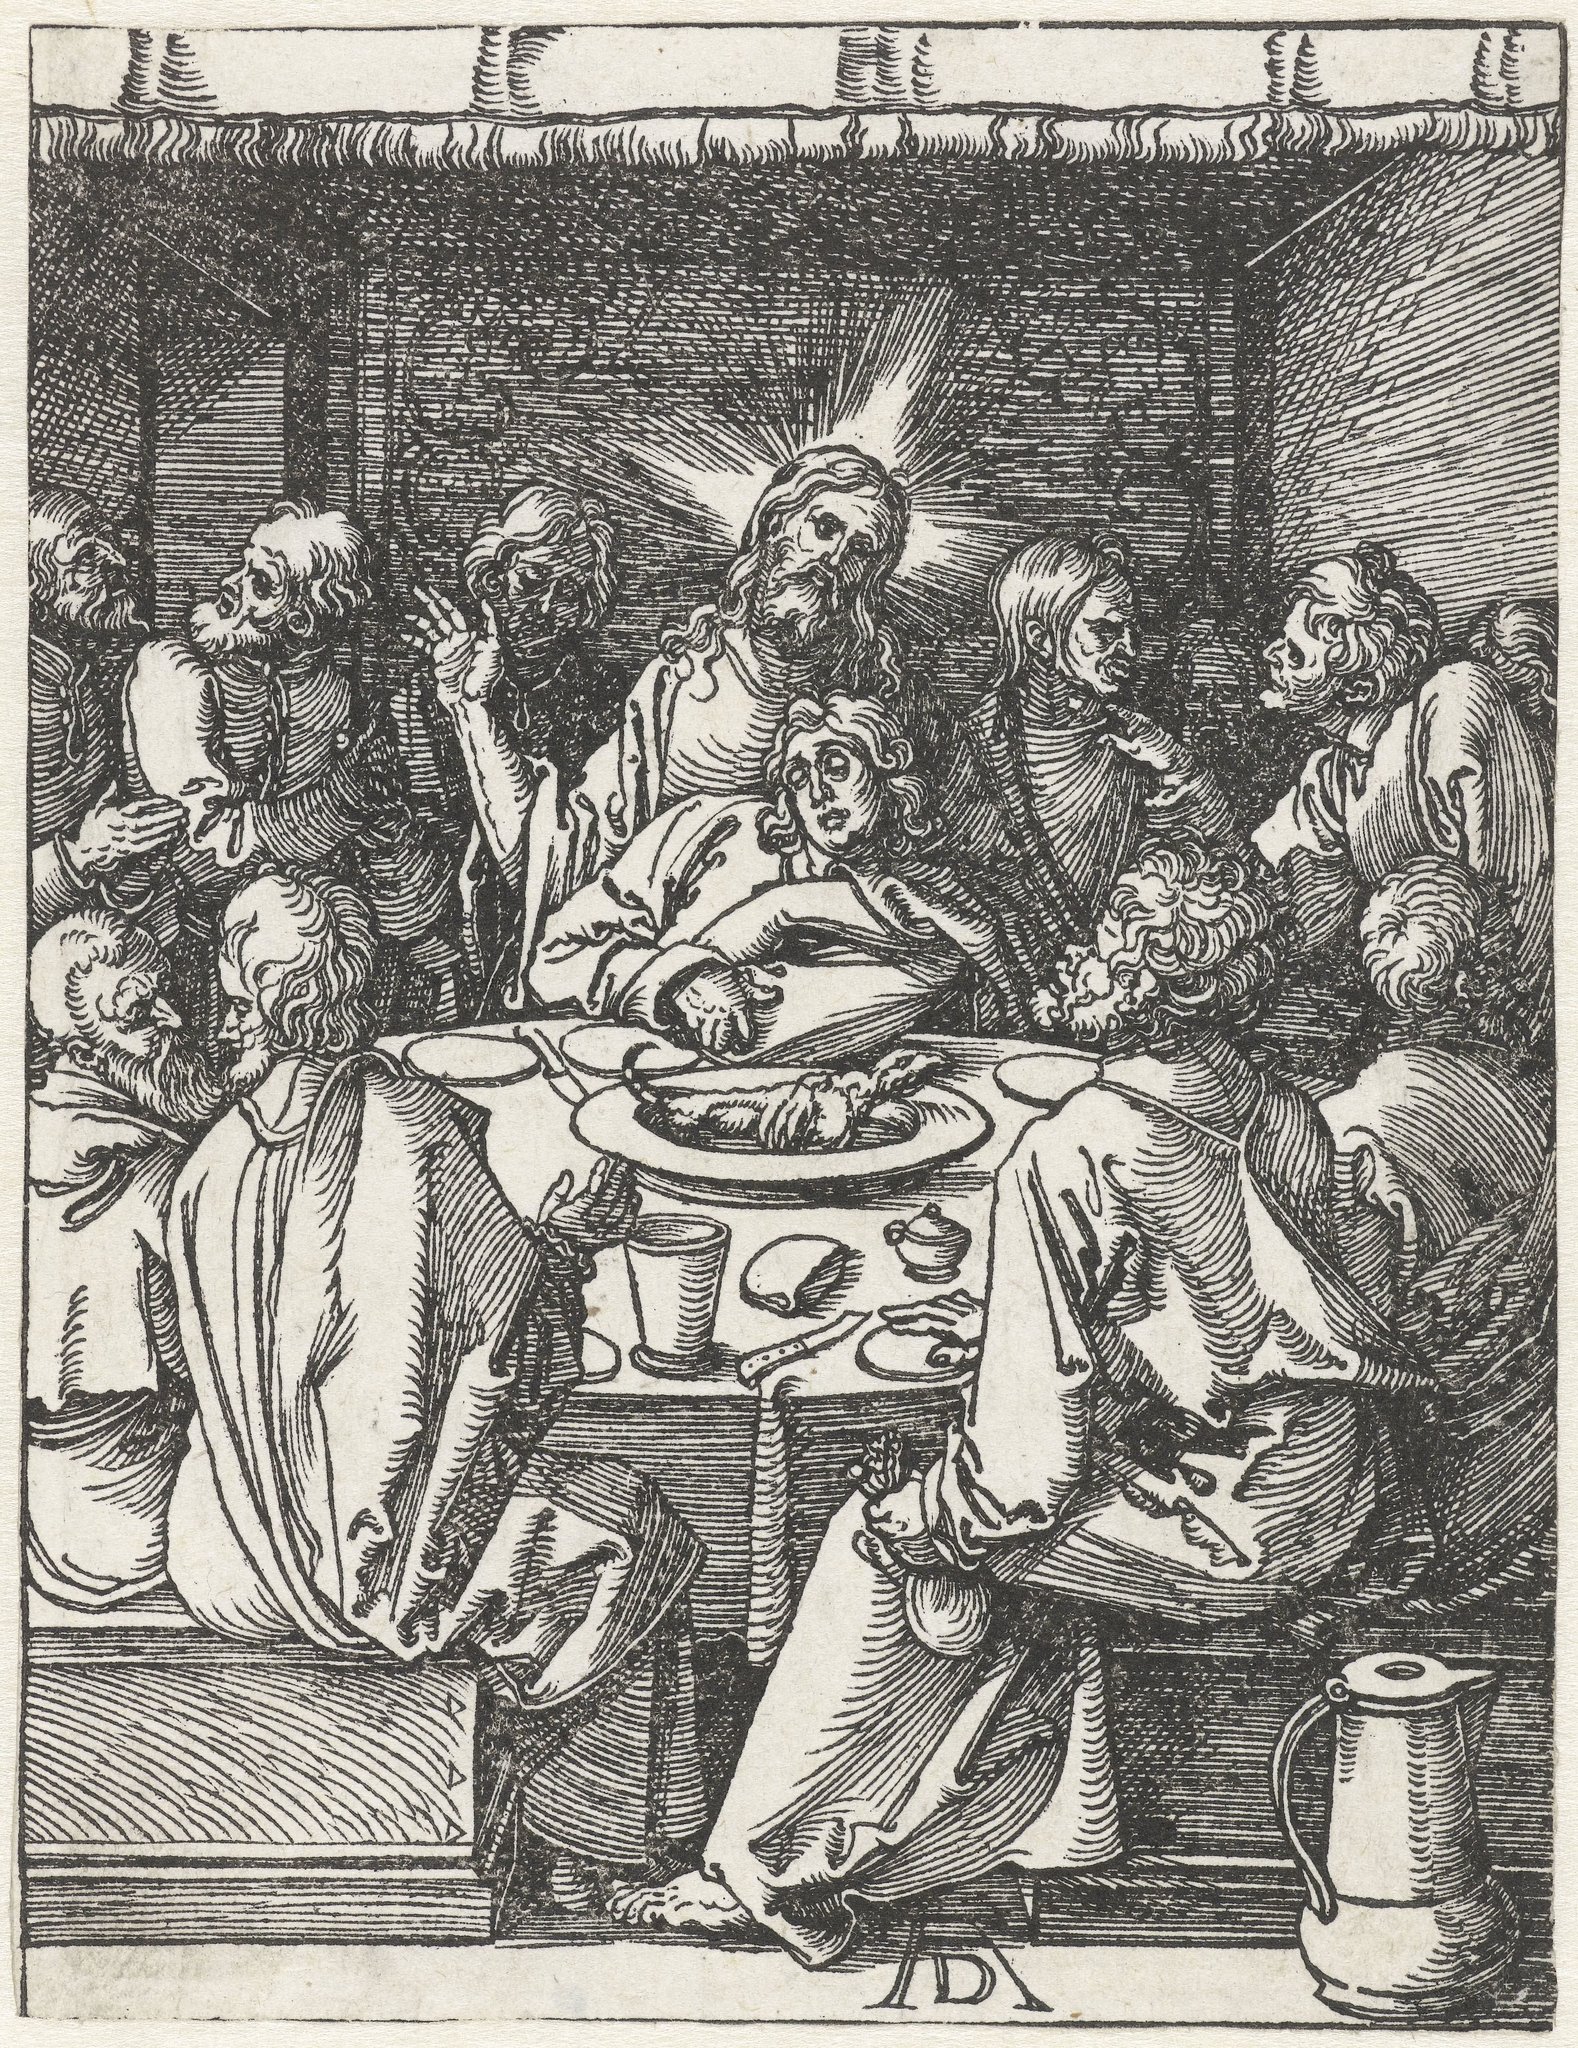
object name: print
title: Laatste Avondmaal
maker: albrecht dürer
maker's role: draughtsman, painter, print maker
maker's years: 1471-1528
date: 1508-1509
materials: paper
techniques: woodcut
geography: nuremberg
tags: last supper (in general) (matthew 26:21-35; mark 14:18-31; luke 22:3, 22:15-23; john 13:21-38)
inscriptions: collector's mark: Lugt 2228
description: Johannes vleit zich aan de borst van Christus tijdens het Laatste Avondmaal. Deze prent is onderdeel van de prentserie 'De kleine Passie', bestaande uit een titelprent en 36 bijbelse scènes (voornamelijk uit het Lijdensverhaal).